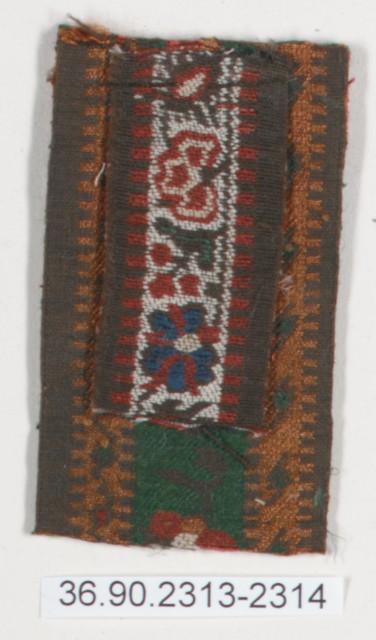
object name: border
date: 1801-1900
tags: flowers